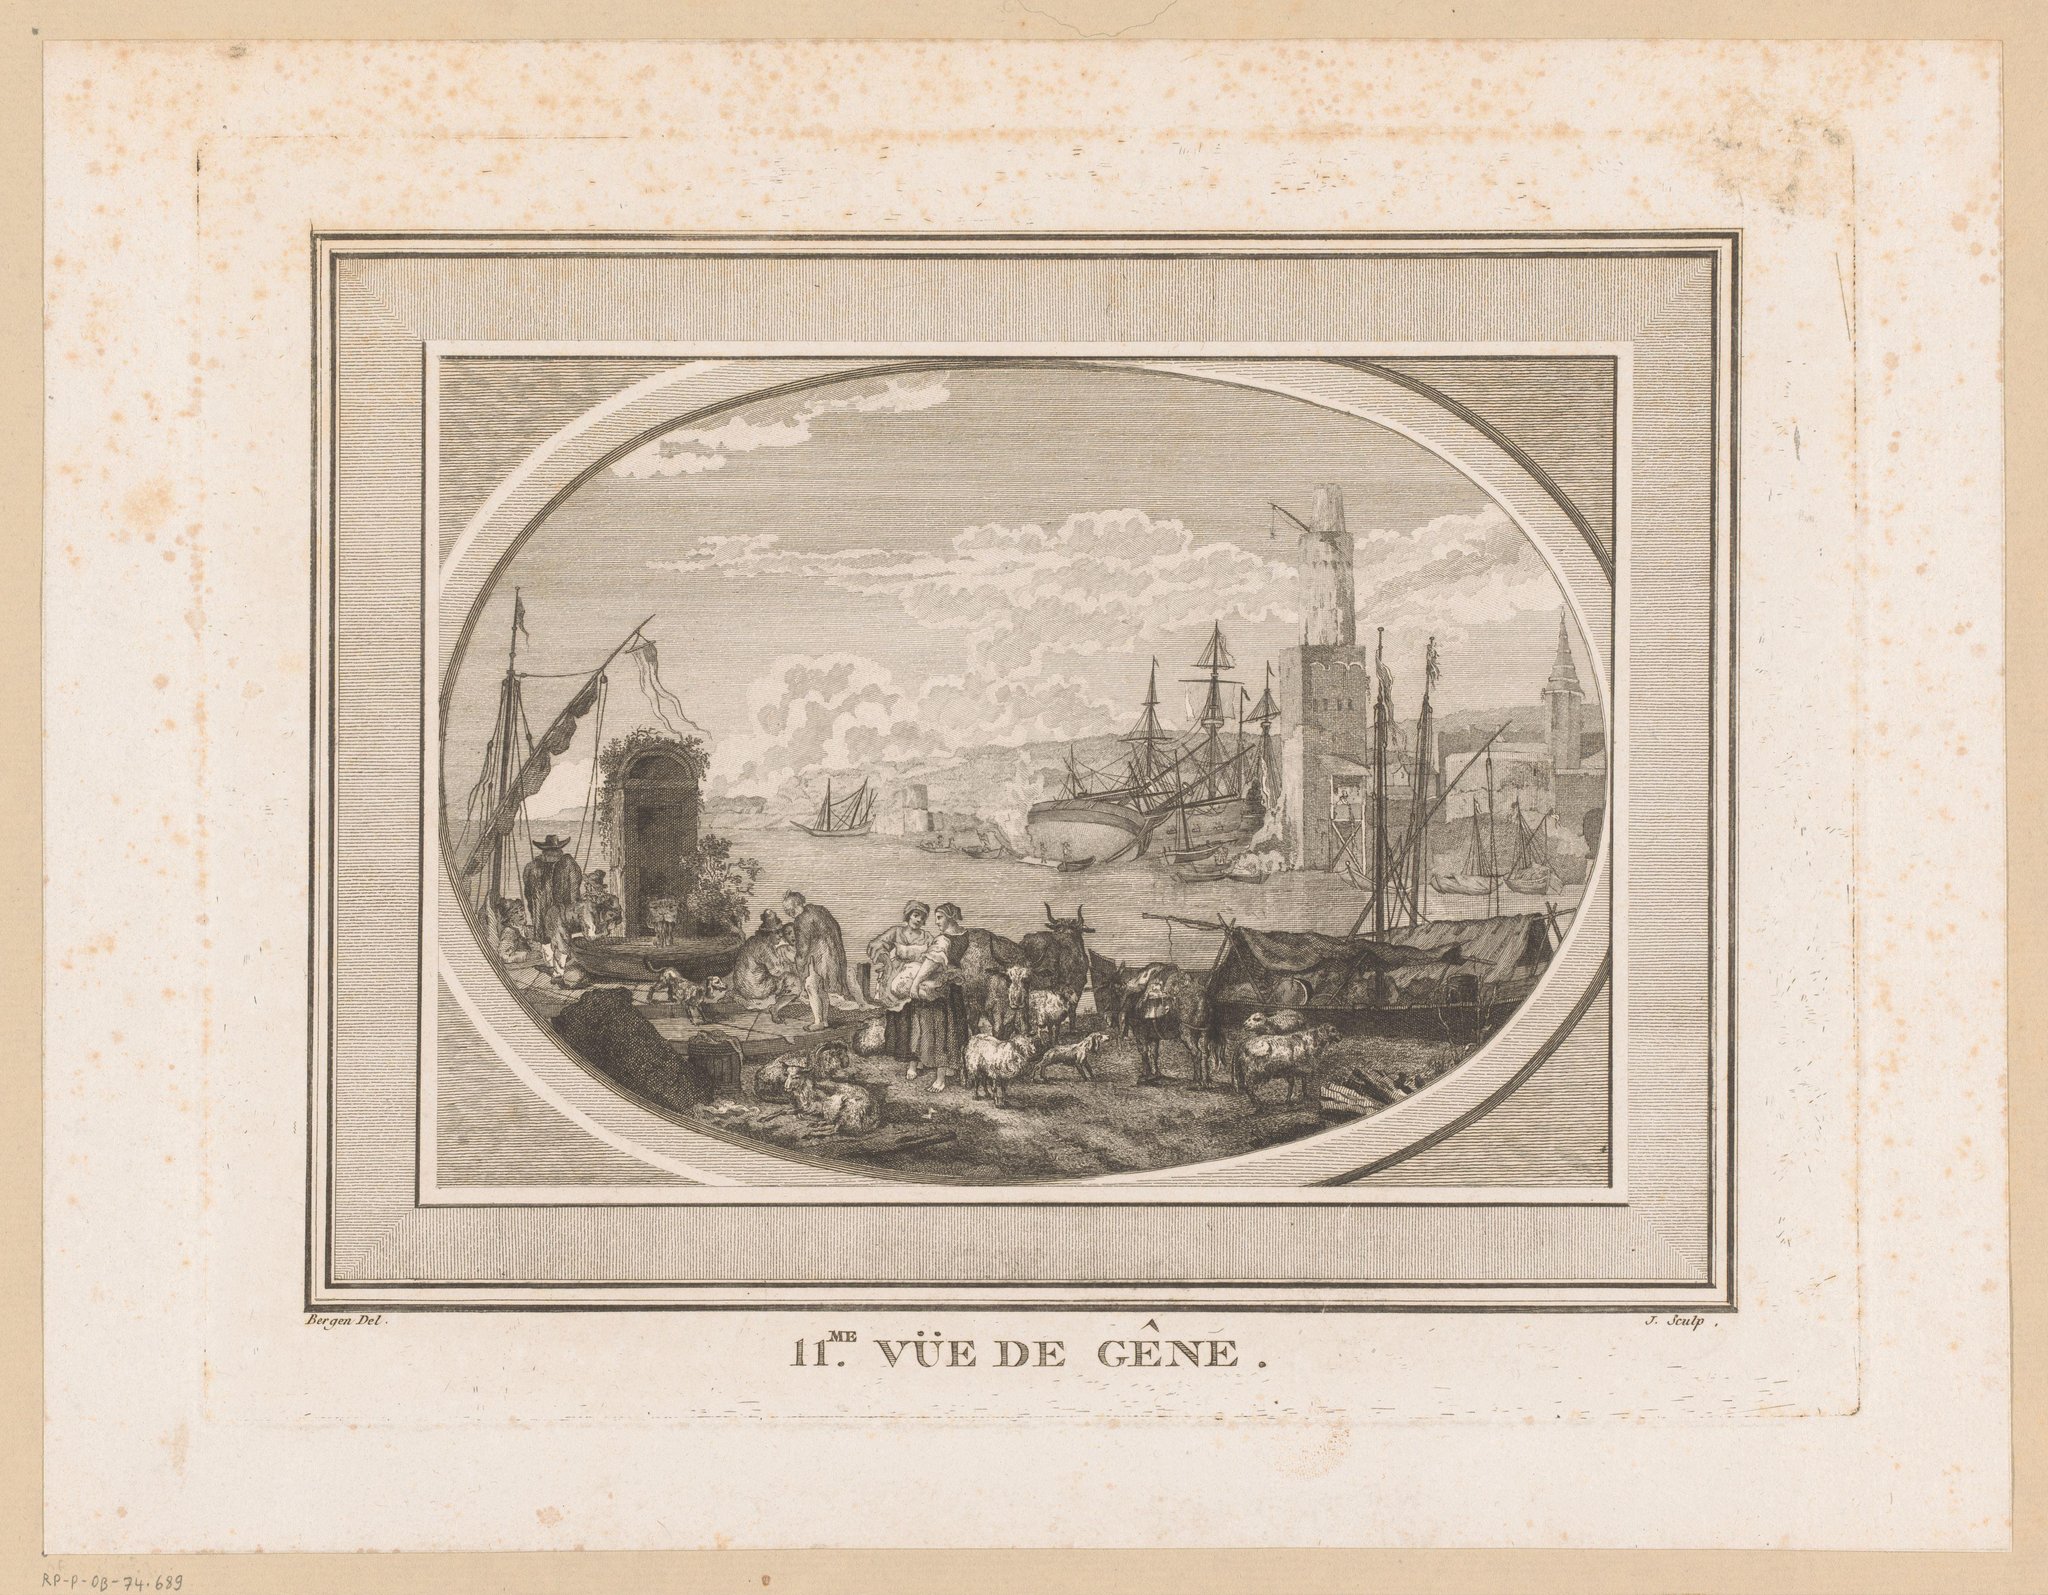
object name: print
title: Gezicht op Gênes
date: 1750-1814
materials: paper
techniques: etching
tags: harbour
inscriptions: collector's mark: Lugt 240